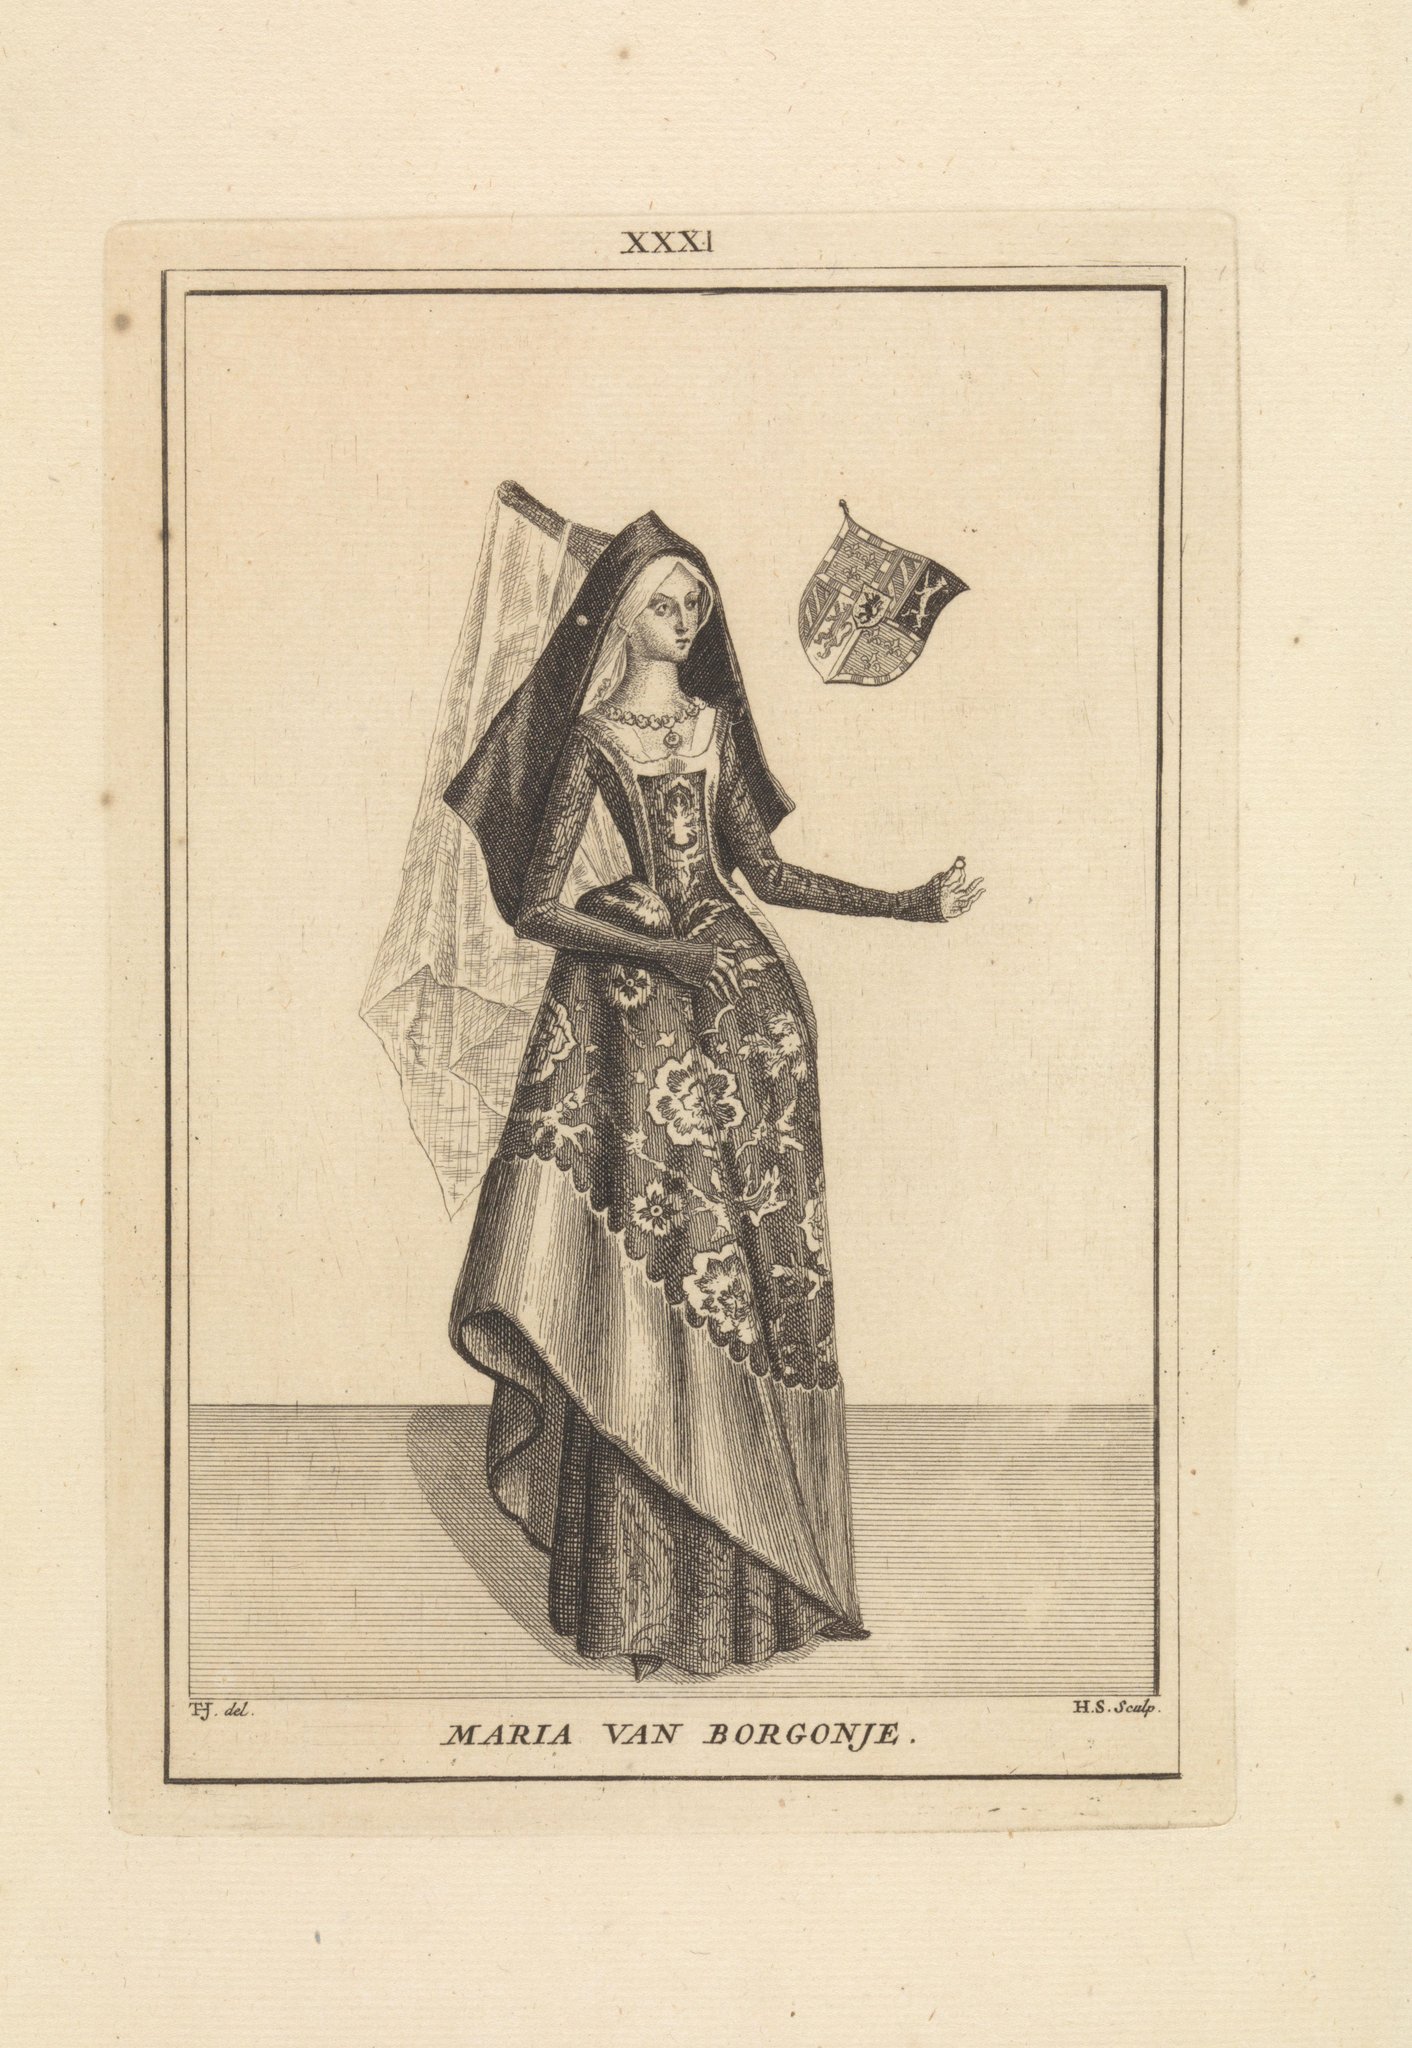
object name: book illustration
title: Portret van Maria van Bourgondië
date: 1745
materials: paper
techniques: etching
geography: haarlem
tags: brussels, maria (hertogin van bourgondië), nobility and patriciate; chivalry, knighthood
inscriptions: collector's mark: Lugt 2228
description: Boekillustratie voor: Langendyk, Pieter. De Graaven van Holland, in jaardichten beschreven door Pieter Langendyk. Verykt met alle de beeldtenissen dier prinsen, naauwkeurig getekend naar de echte aloude tafereelen of de zaal van't raadhuis der stad Haarlem. Haarlem: J. Bosch, 1745.